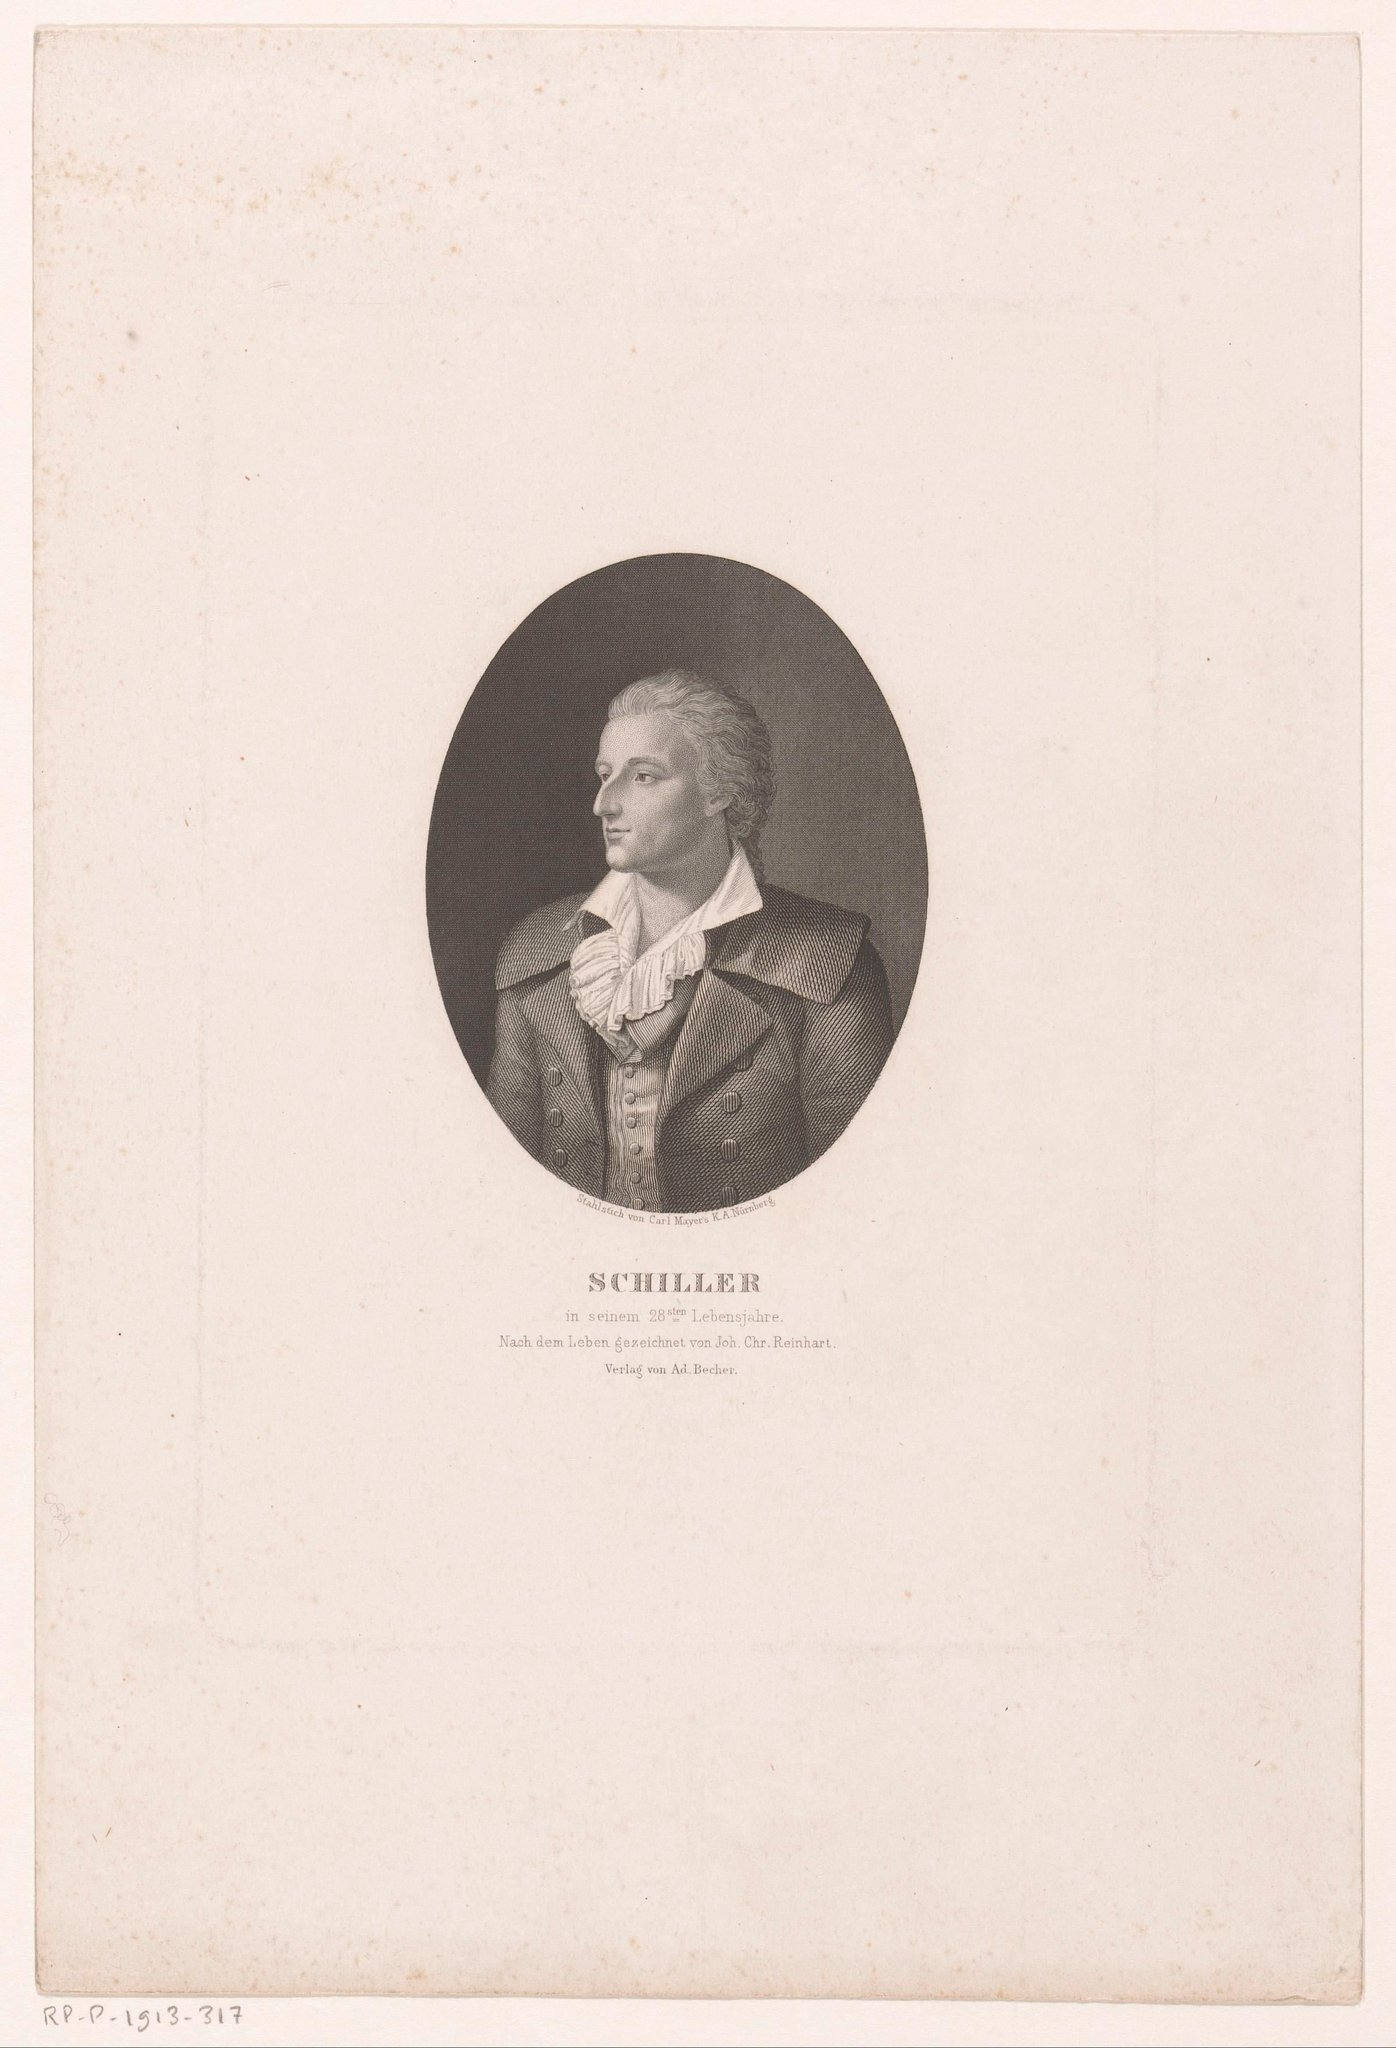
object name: print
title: Portret van Friedrich von Schiller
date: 1808-1868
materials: paper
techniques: engraving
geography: stuttgart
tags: friedrich von schiller, historical persons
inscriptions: collector's mark: Lugt 2228